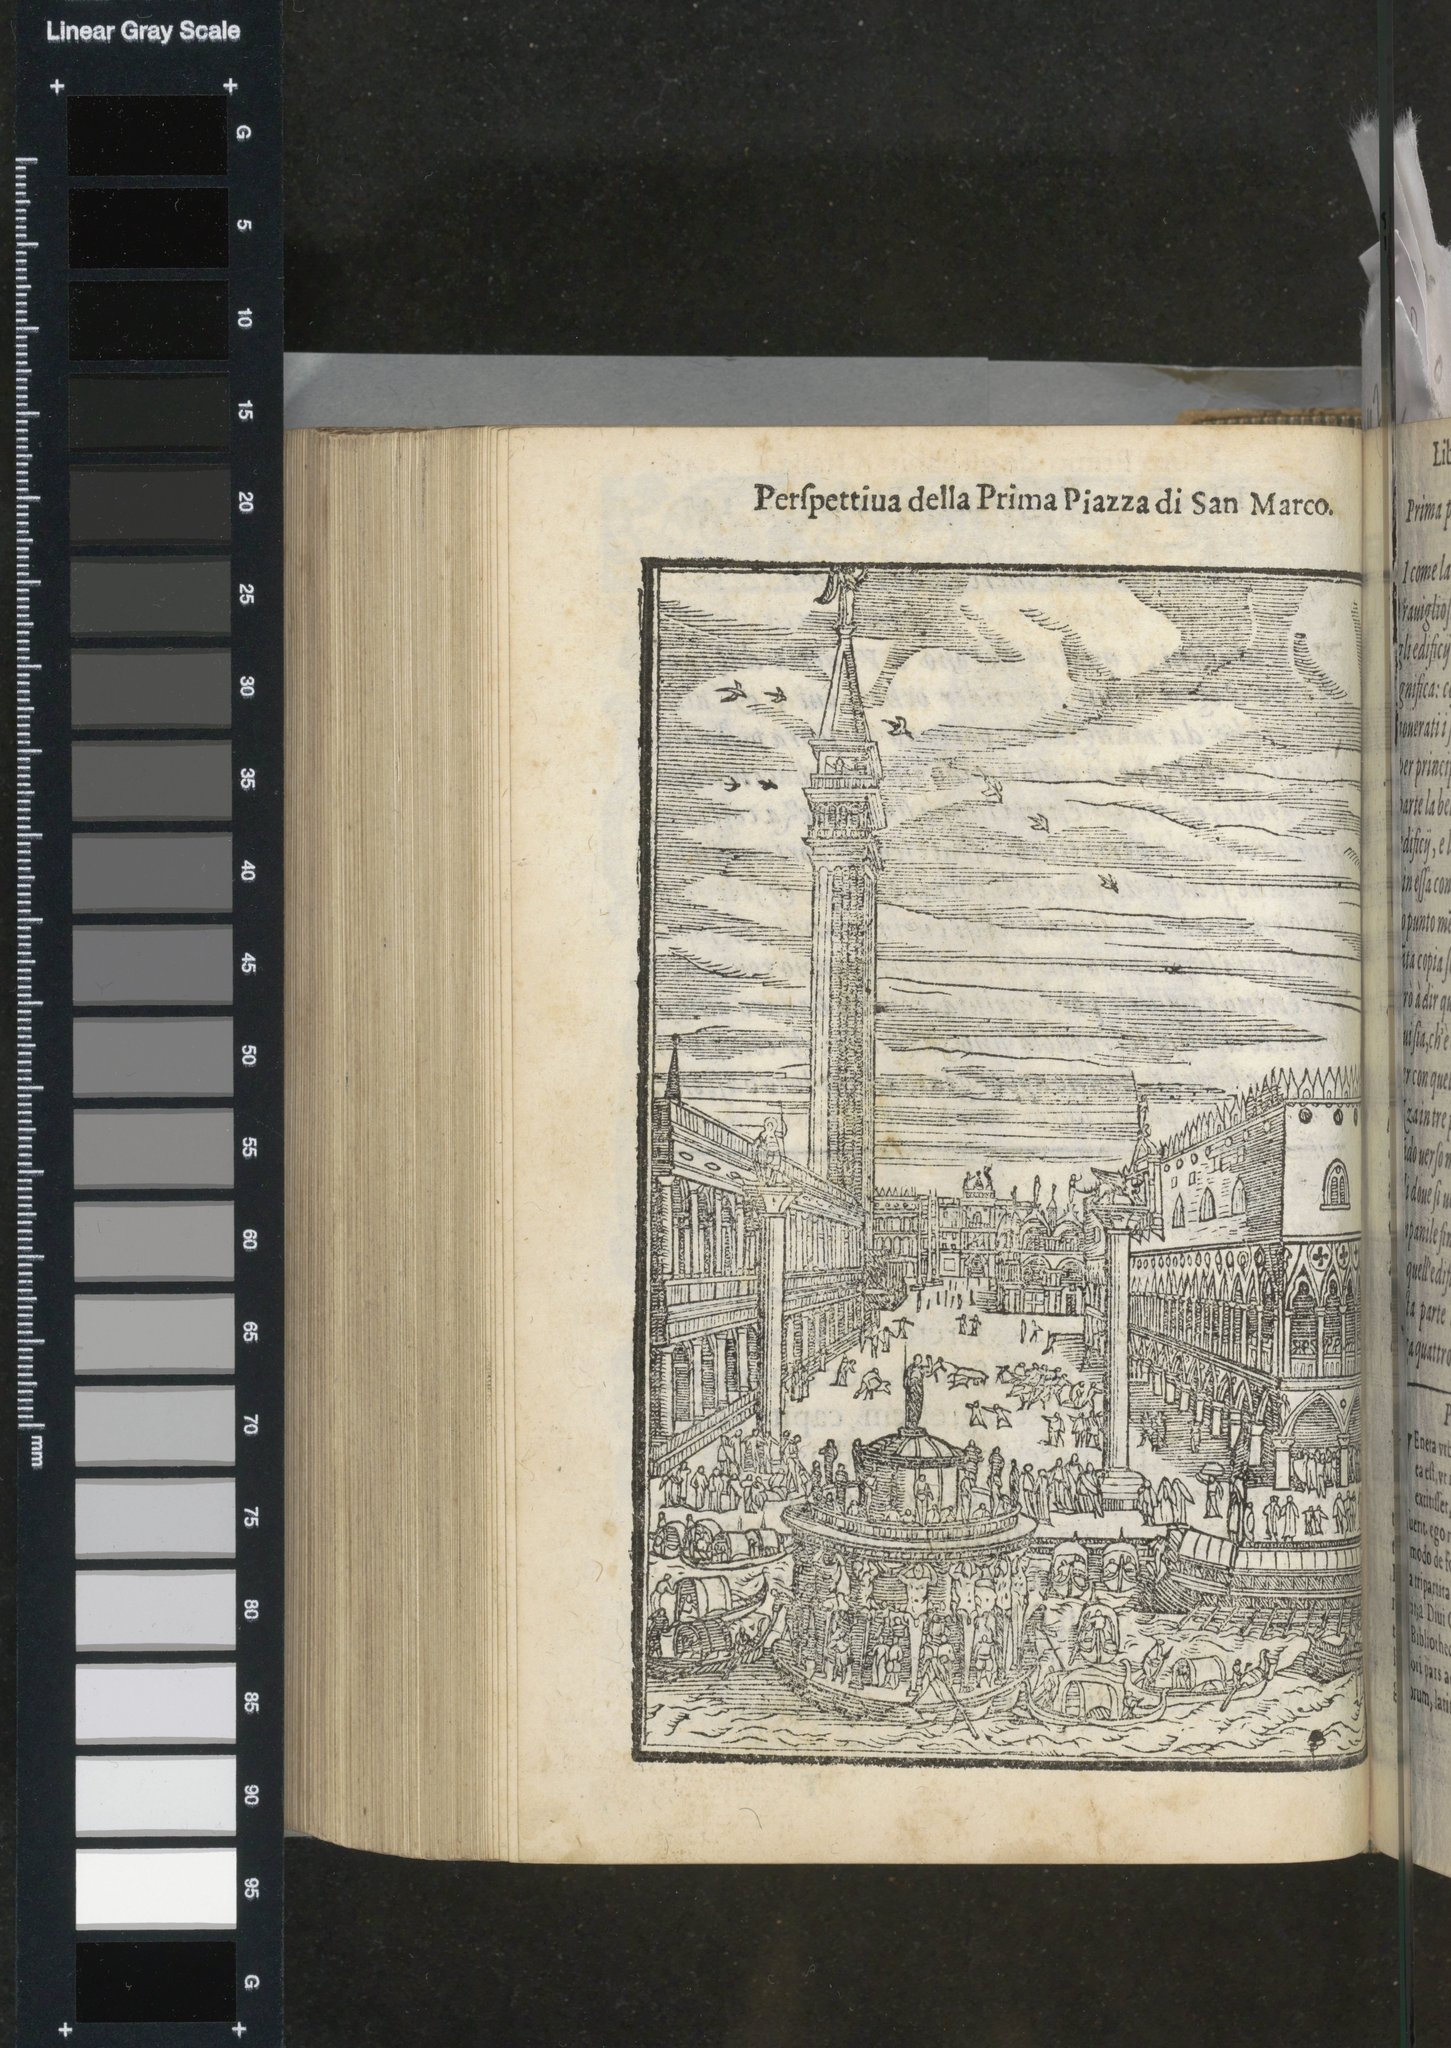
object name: costume print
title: Habiti antichi, et moderni di tutto il mondo...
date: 1598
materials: paper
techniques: woodcut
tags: fashion plates